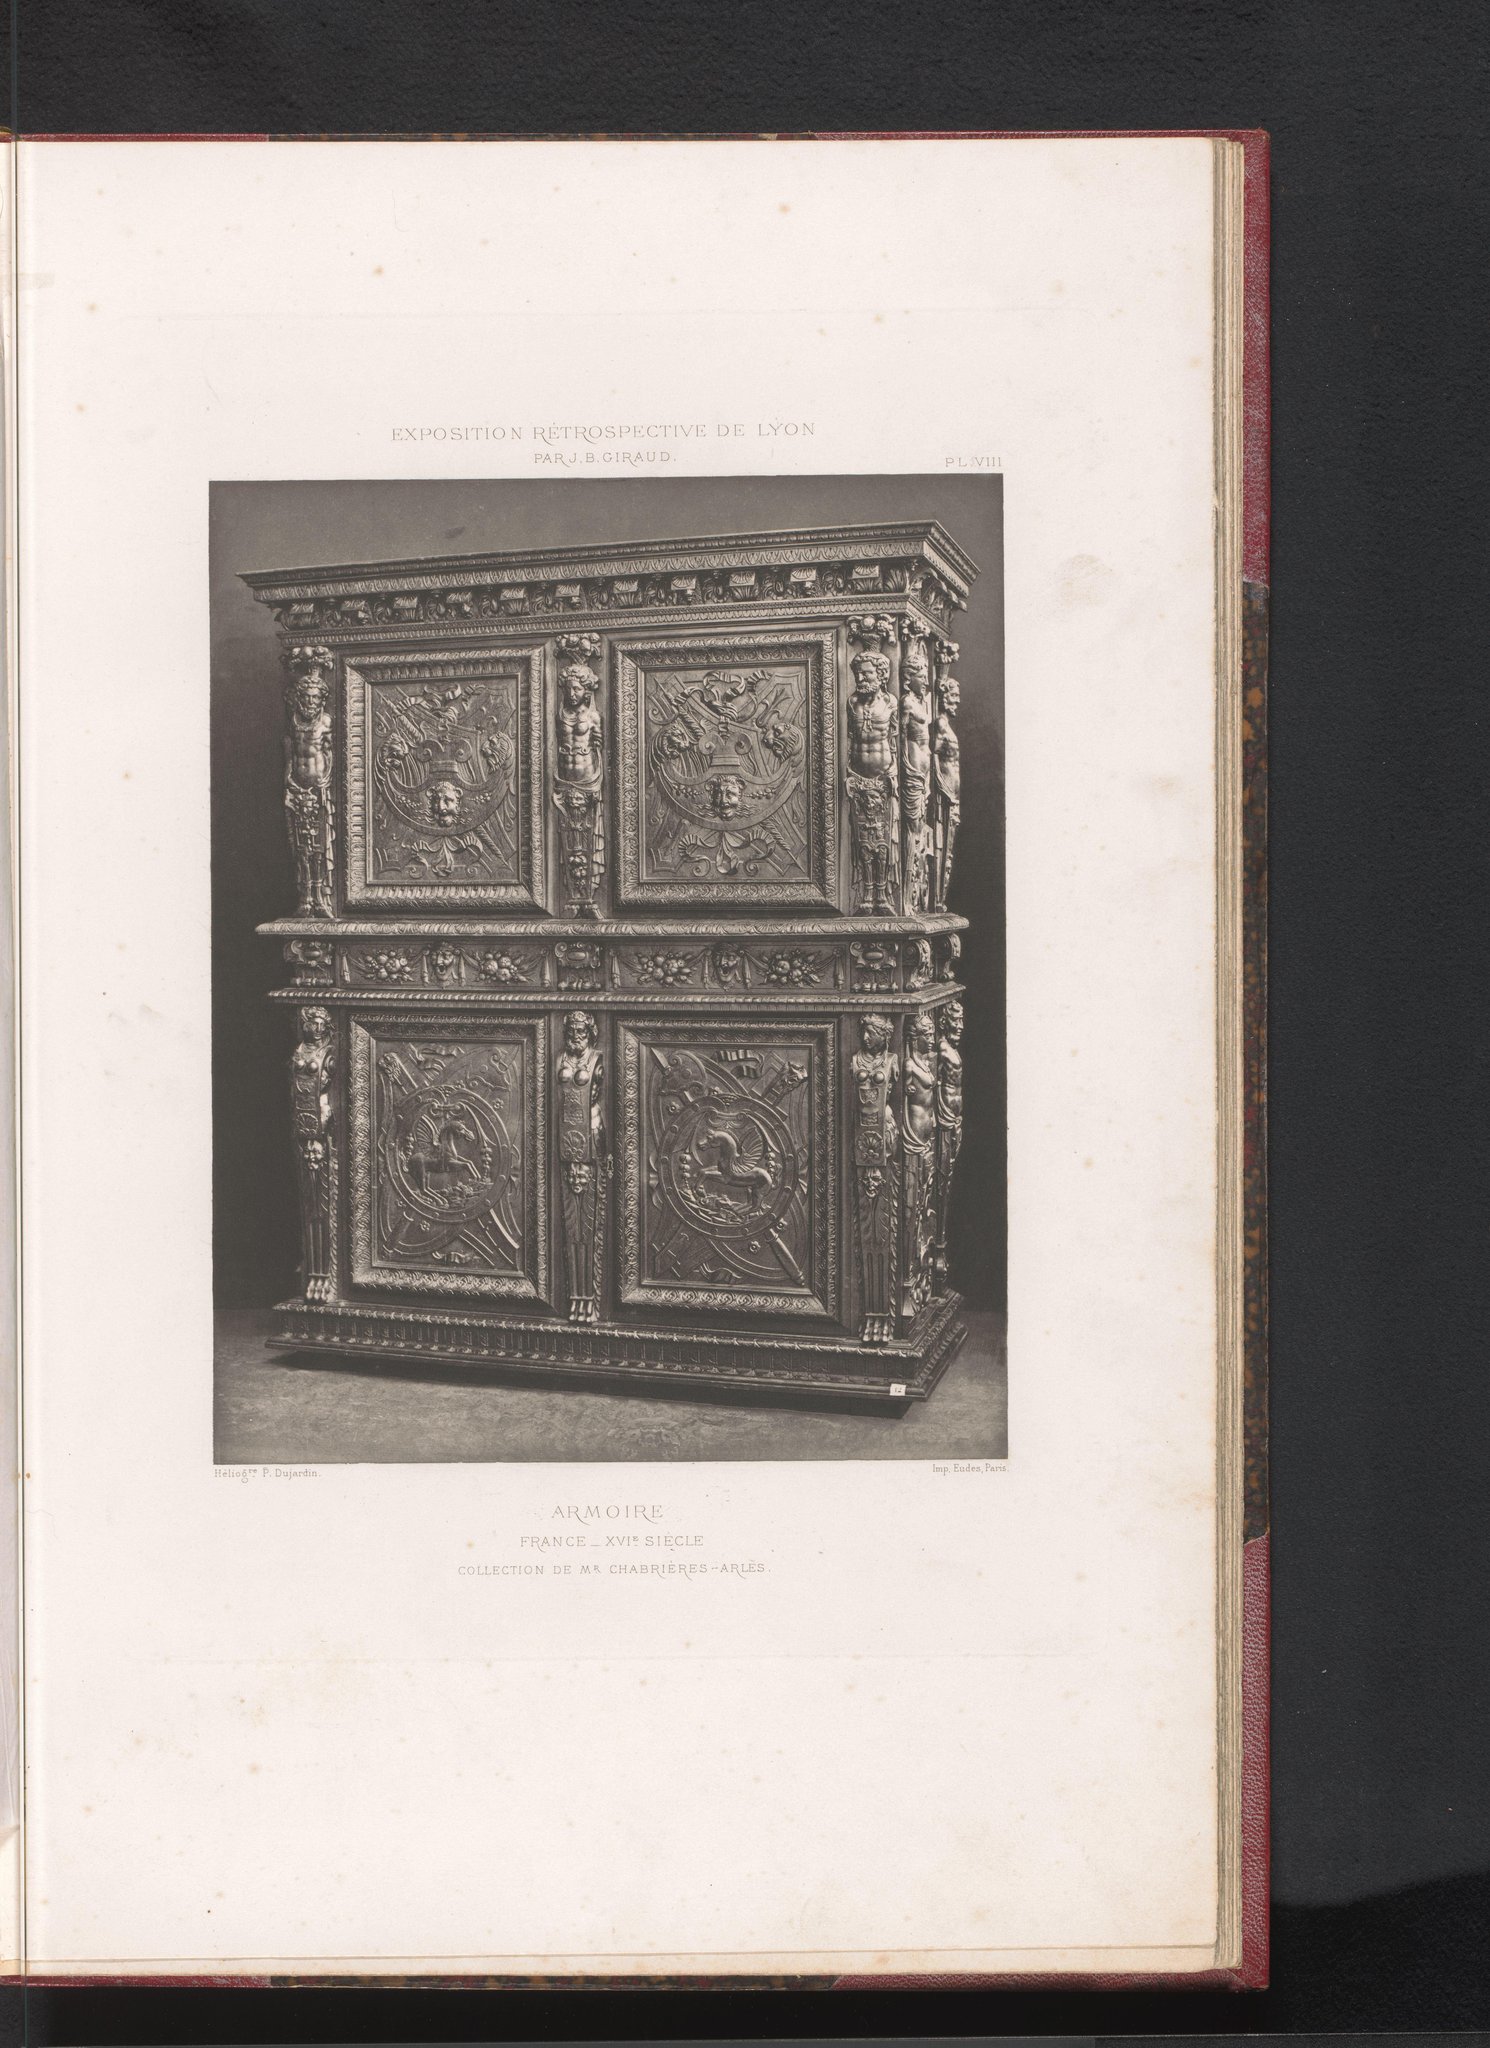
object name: photomechanical print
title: 16de-eeuwse Franse kast van hout, op de Exposition Rétrospective van 1877 in Lyon, Frankrijk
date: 1877-1880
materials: paper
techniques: photoaquatint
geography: paris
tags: ornamental cupboard (+ wood and other phytogenic material), lyon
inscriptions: number: ‘PL. VIII.’, inscription: ‘EXPOSITION RÉTROSPECTIVE DE LYON/ PAR J. B. GIRAUD.’, inscription: ‘ARMOIRE/ FRANCE_XVIe SIÈCLE/ COLLECTION DE Mr CHABRIÈRES-ARLÈS.’